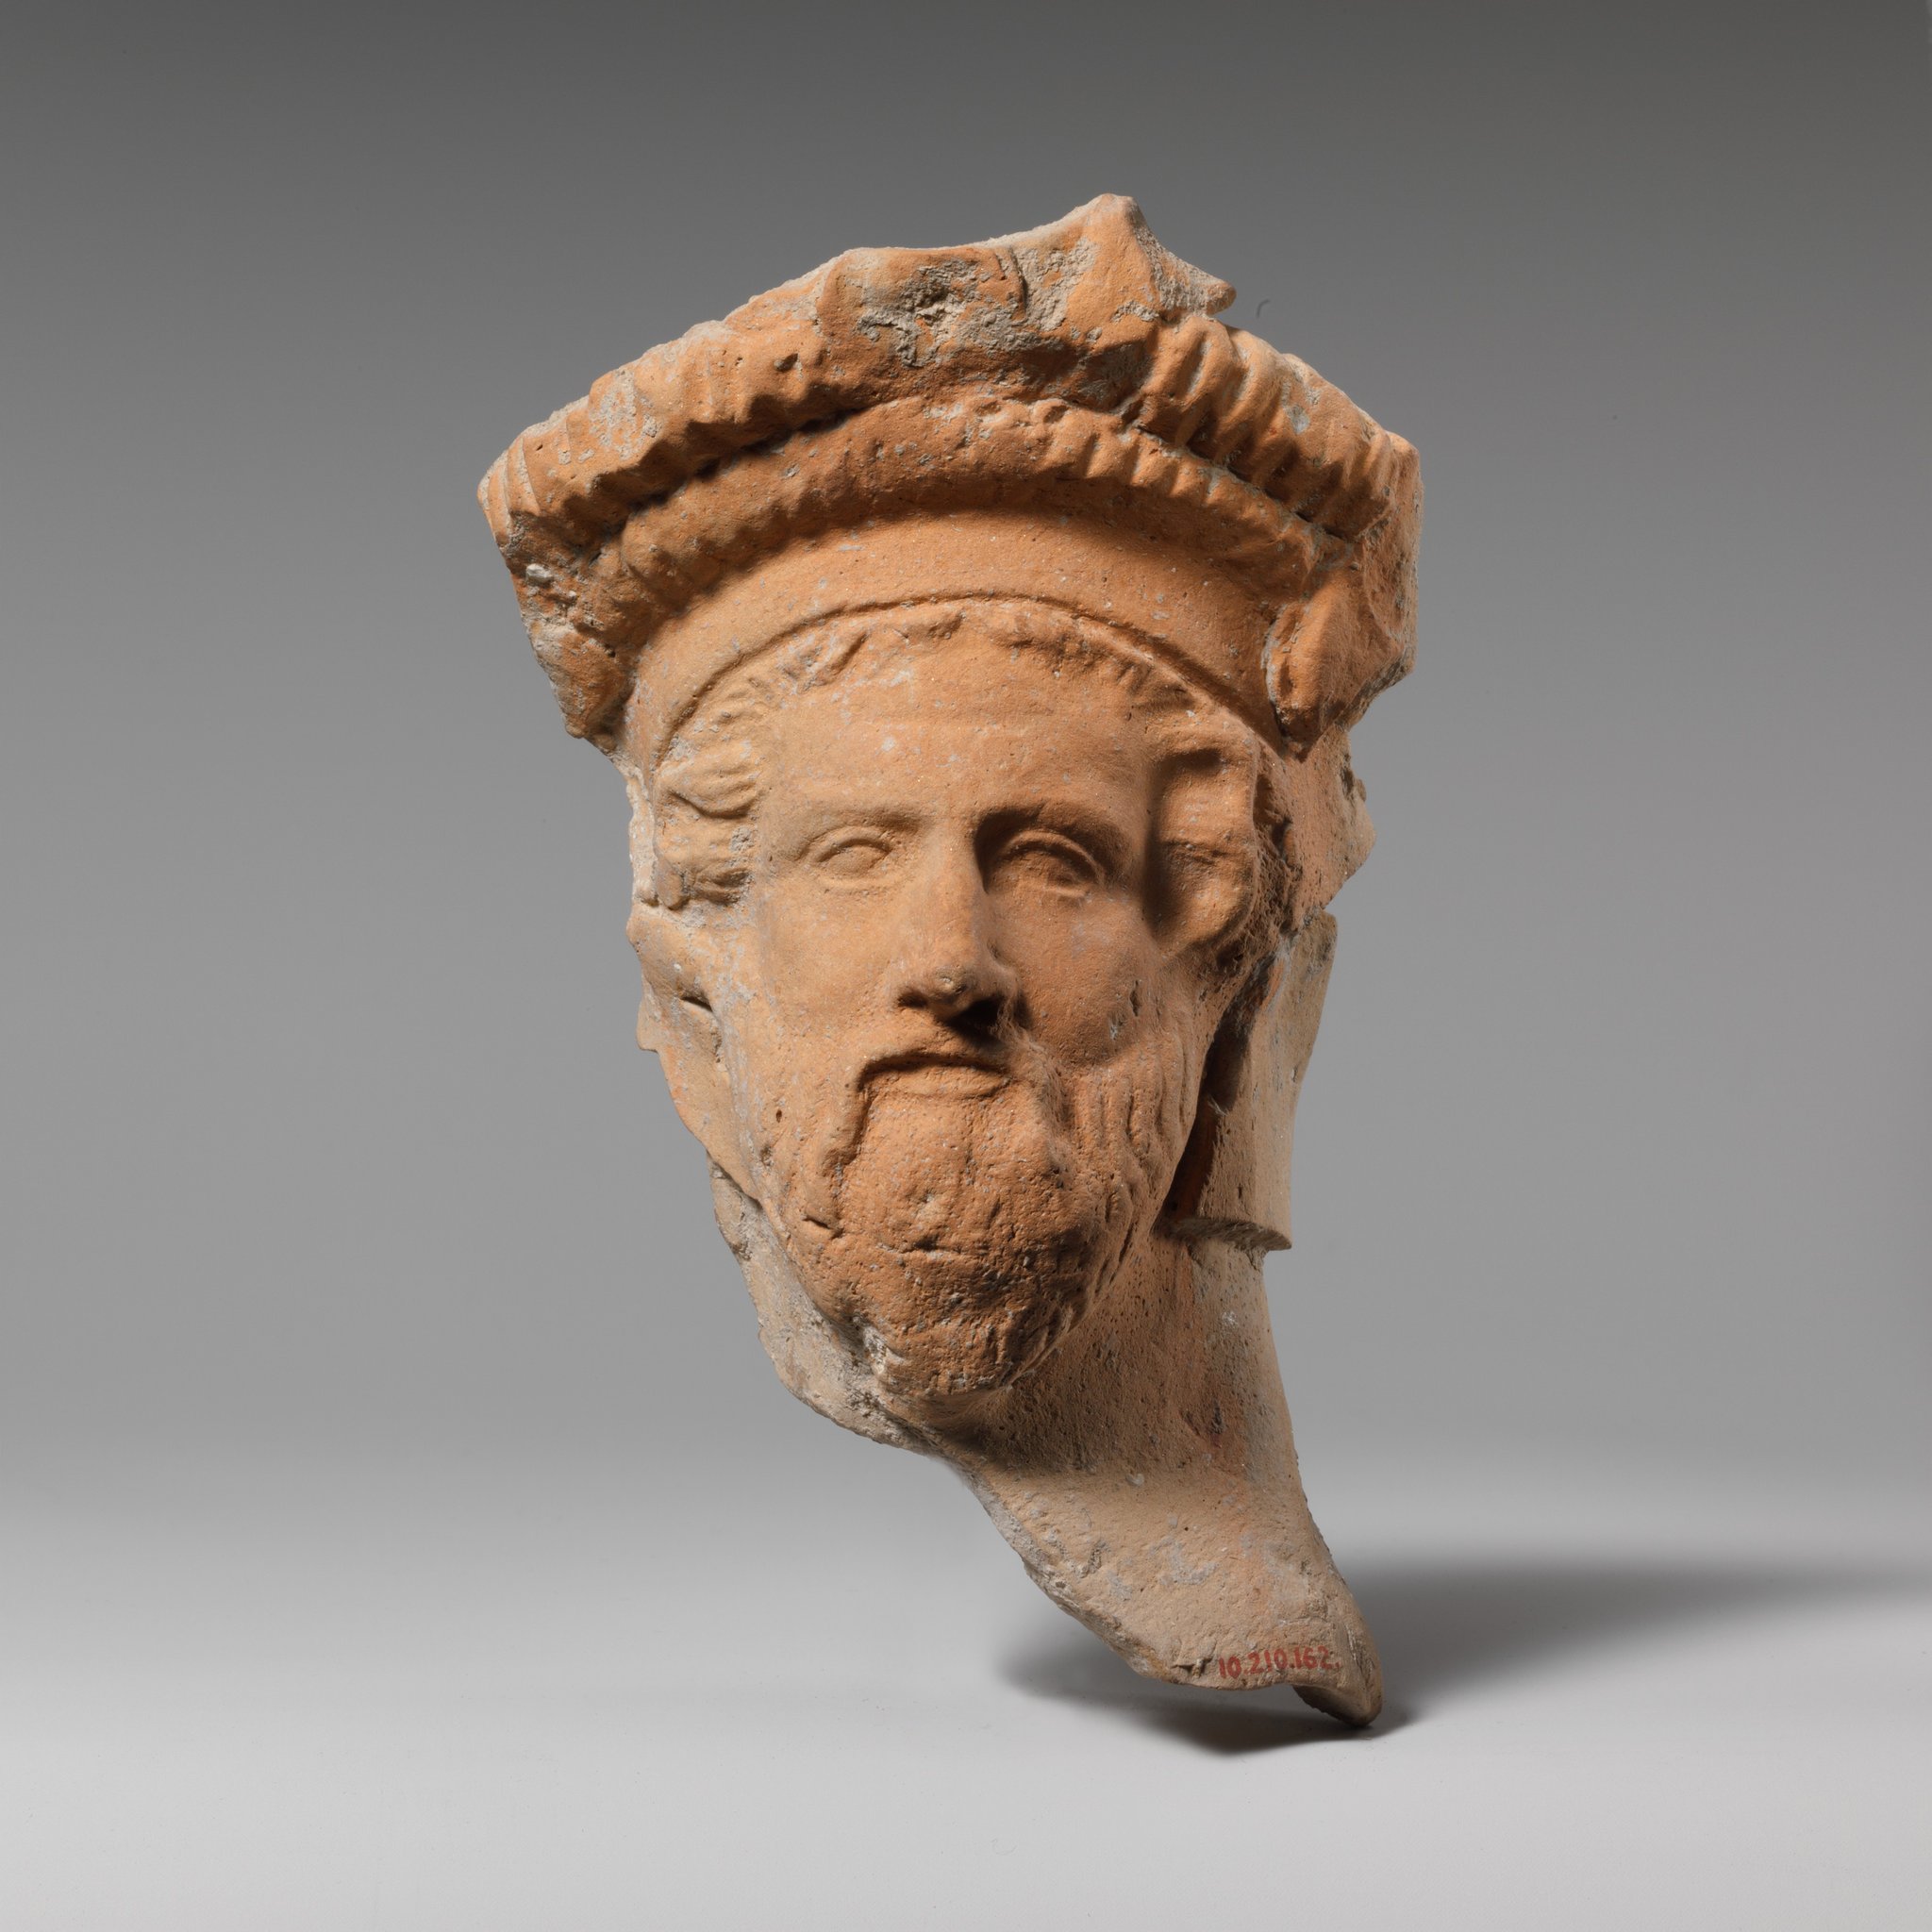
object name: head of dionysos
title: Terracotta head of a man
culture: greek, south italian, tarentine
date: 400-301 BCE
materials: terracotta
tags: heads,men